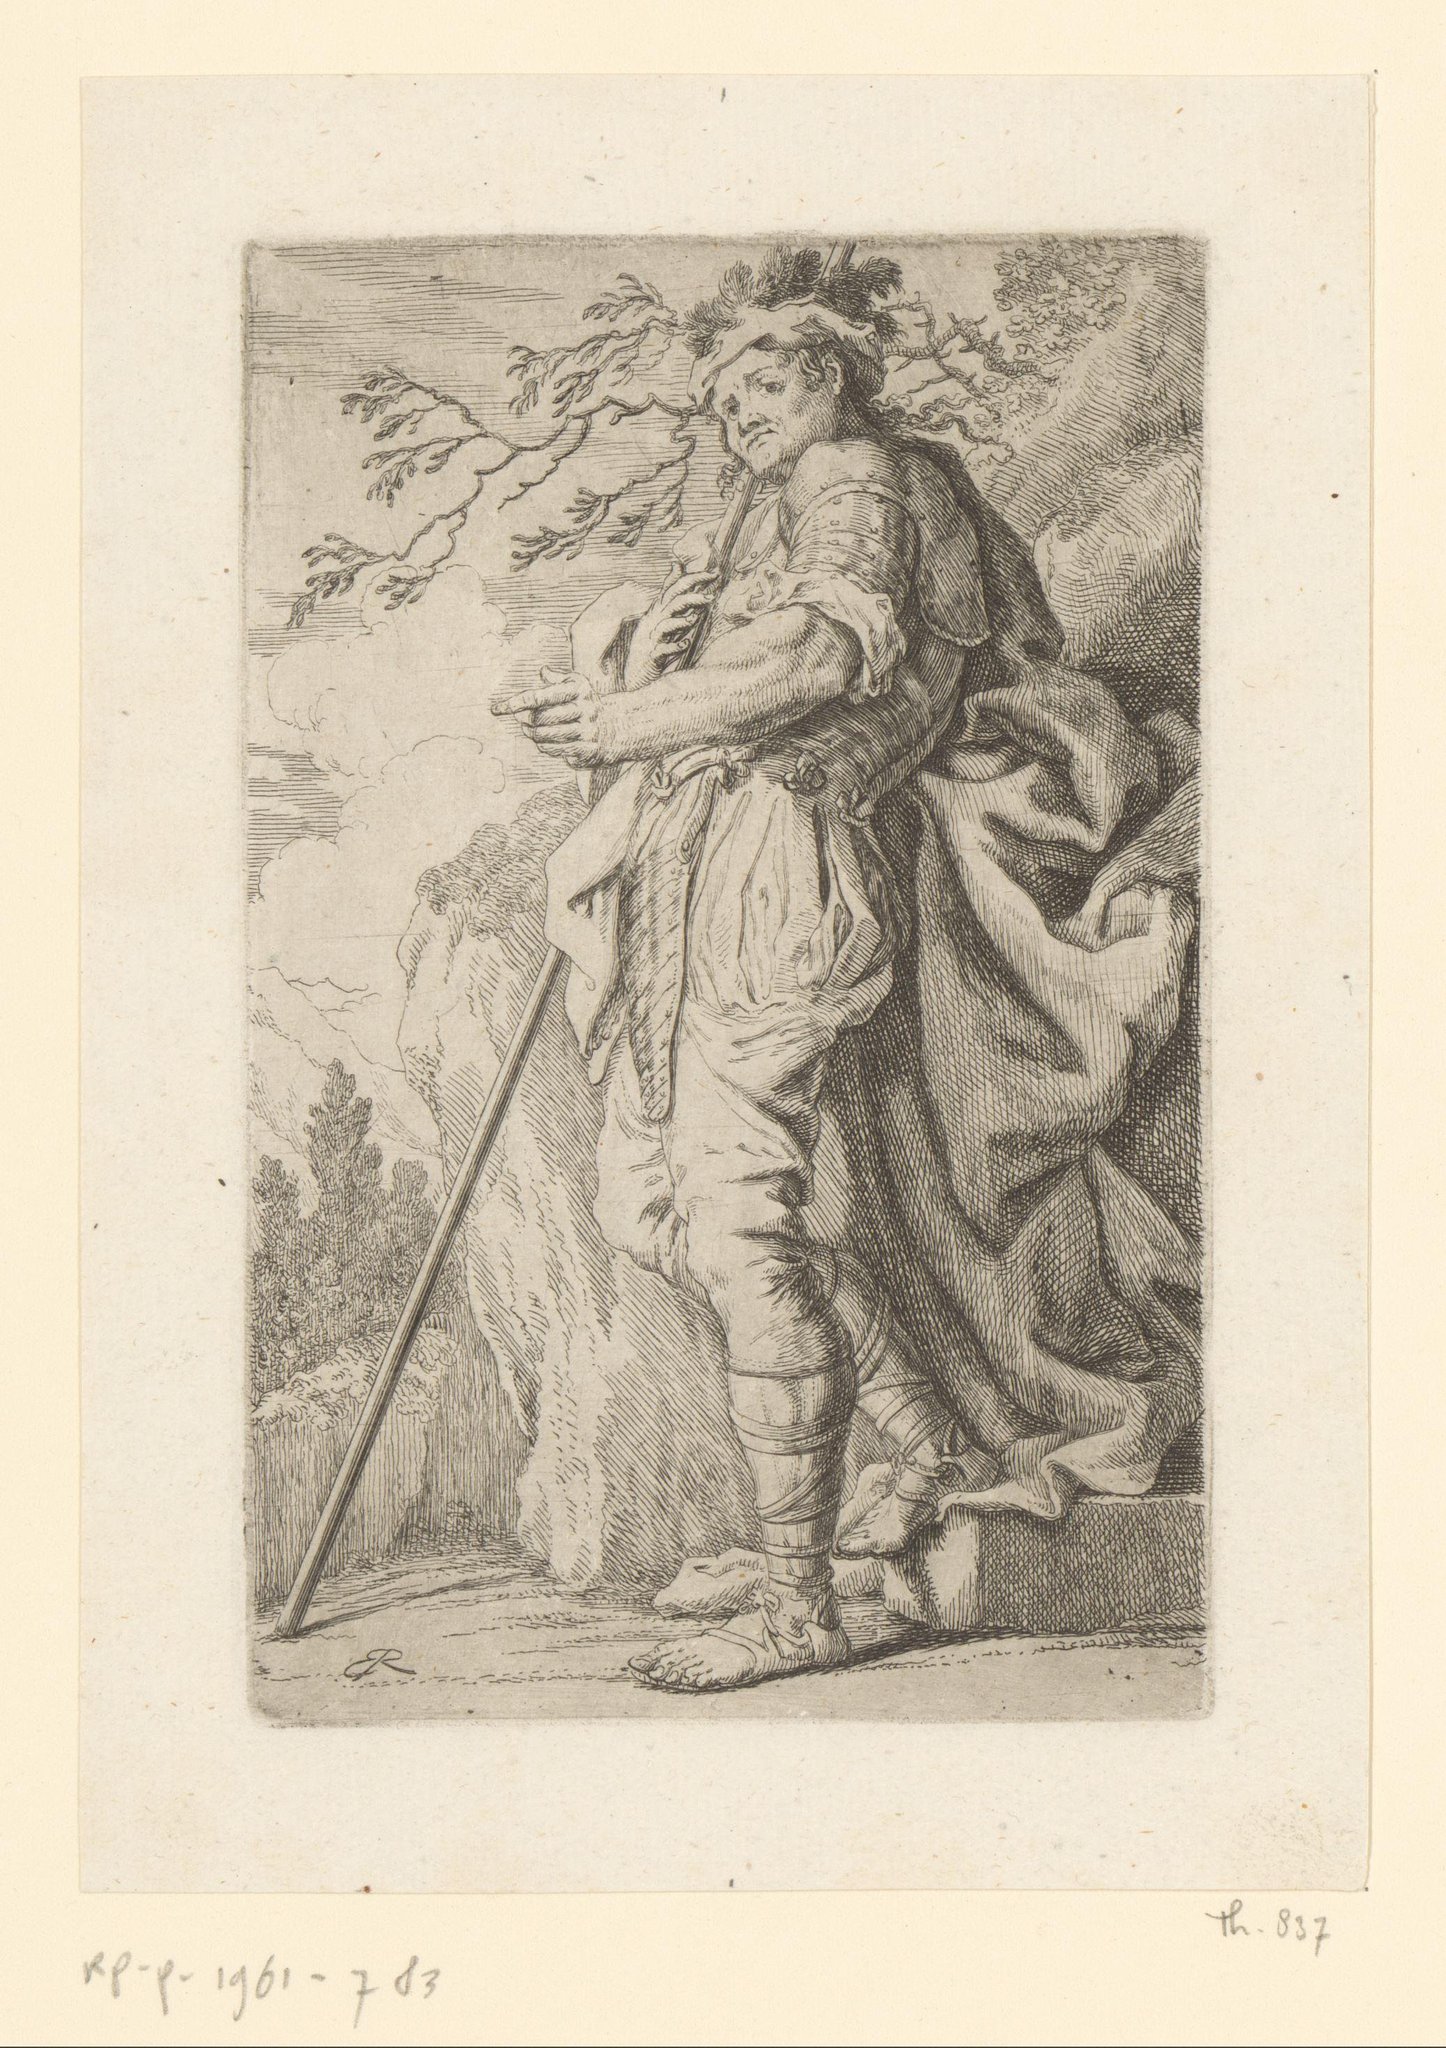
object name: print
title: Krijgsman met lans leunend tegen rots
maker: johann elias ridinger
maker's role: draughtsman, painter, print maker, publisher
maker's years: 1698-1767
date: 1728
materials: paper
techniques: etching, intaglio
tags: helved weapons, polearms (for striking, hacking, thrusting): lance, the soldier; the soldier's life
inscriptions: collector's mark: Lugt 2228